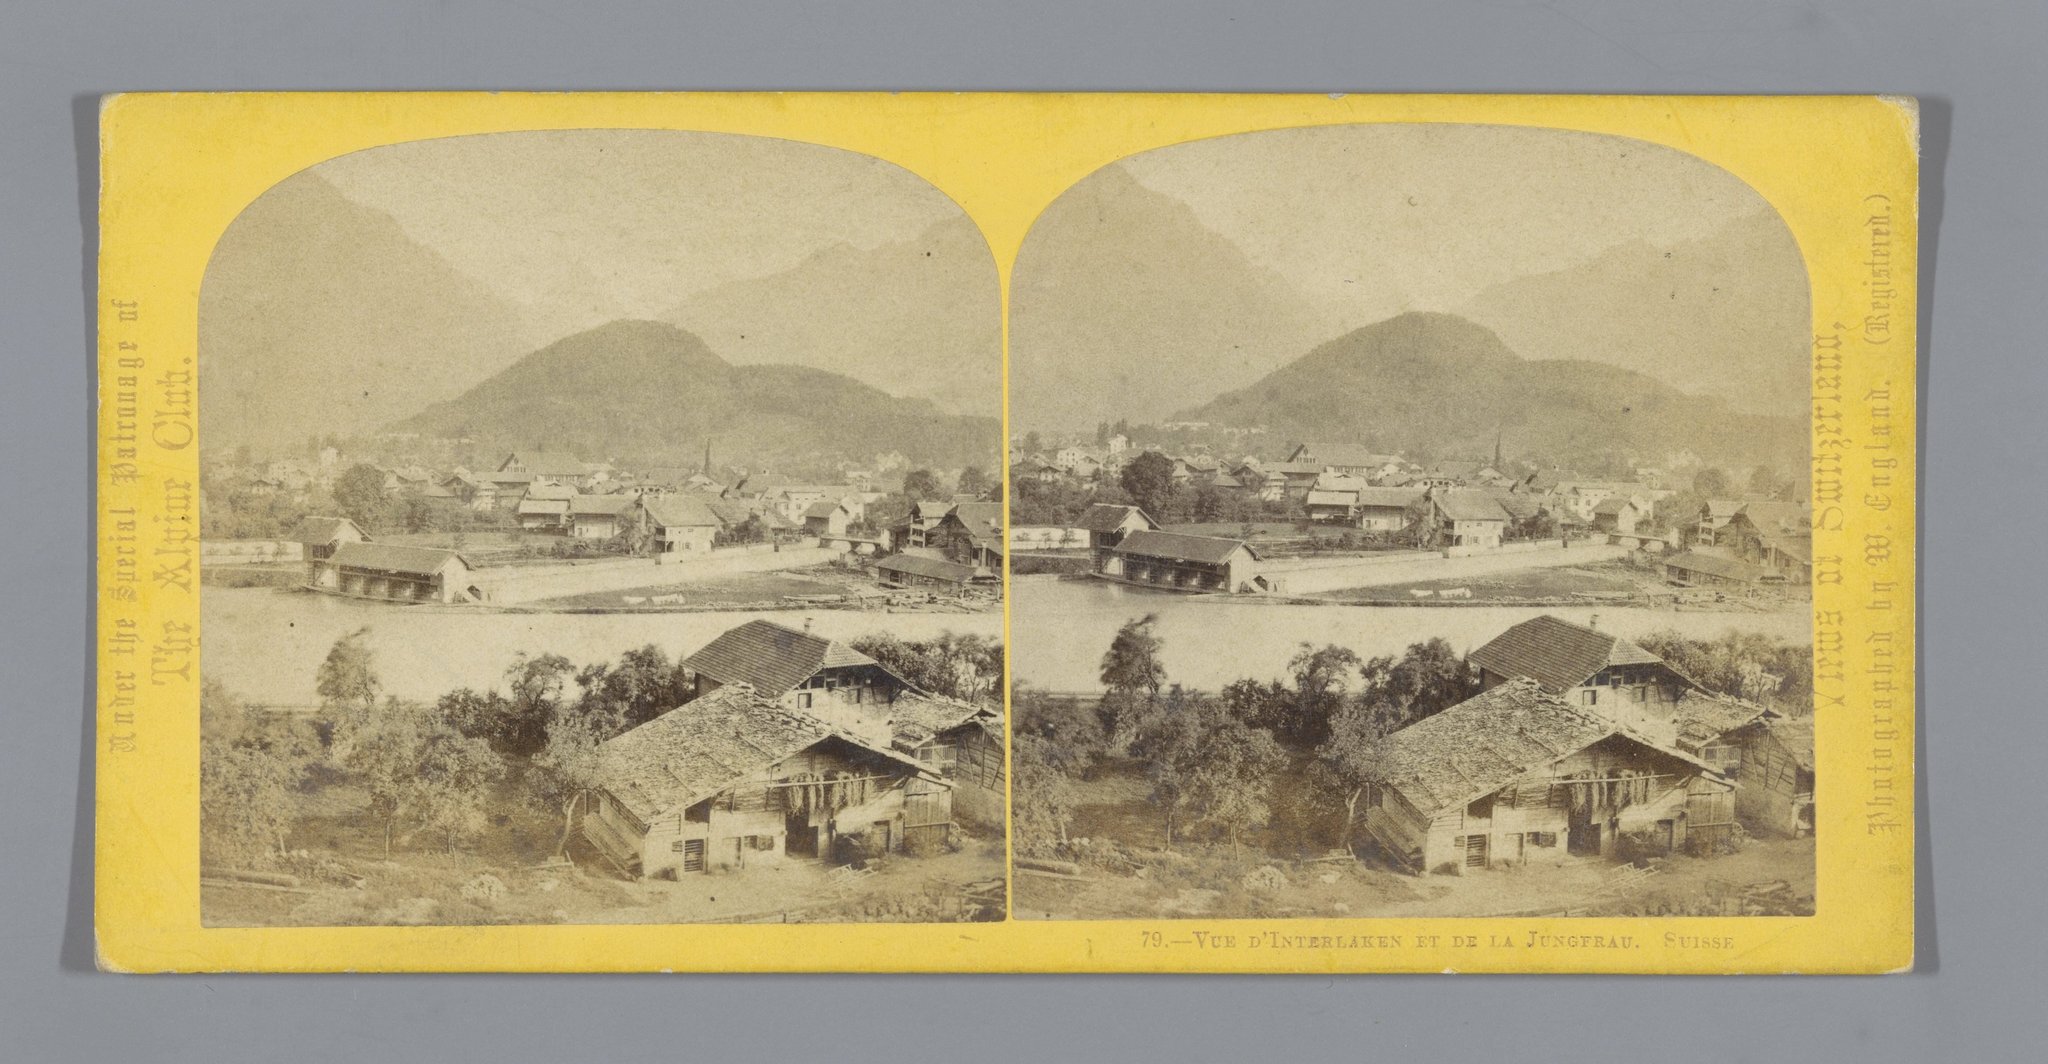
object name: stereograph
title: Gezicht op Interlaken, met op de achtergrond de Jungfrau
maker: william england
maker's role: fotograaf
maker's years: 1816-1896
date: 1850-1880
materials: cardboard, photographic support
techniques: albumen print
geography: bern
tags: city-view in general; 'veduta', mountains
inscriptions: number: ‘79.’, inscription: ‘Views of Switzerland, photographed by W. England. (Registered) Under the Special Patronage of the Alpine Club.’